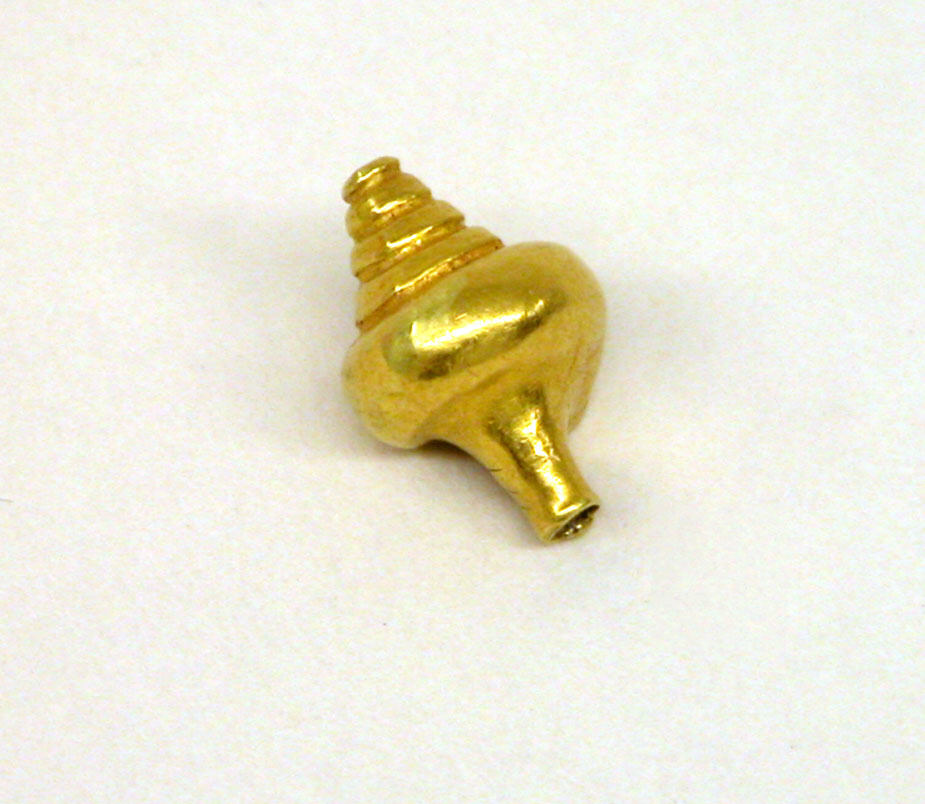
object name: ornament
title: Ornament in the Shape of a Shankha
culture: indonesian, javanese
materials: gold